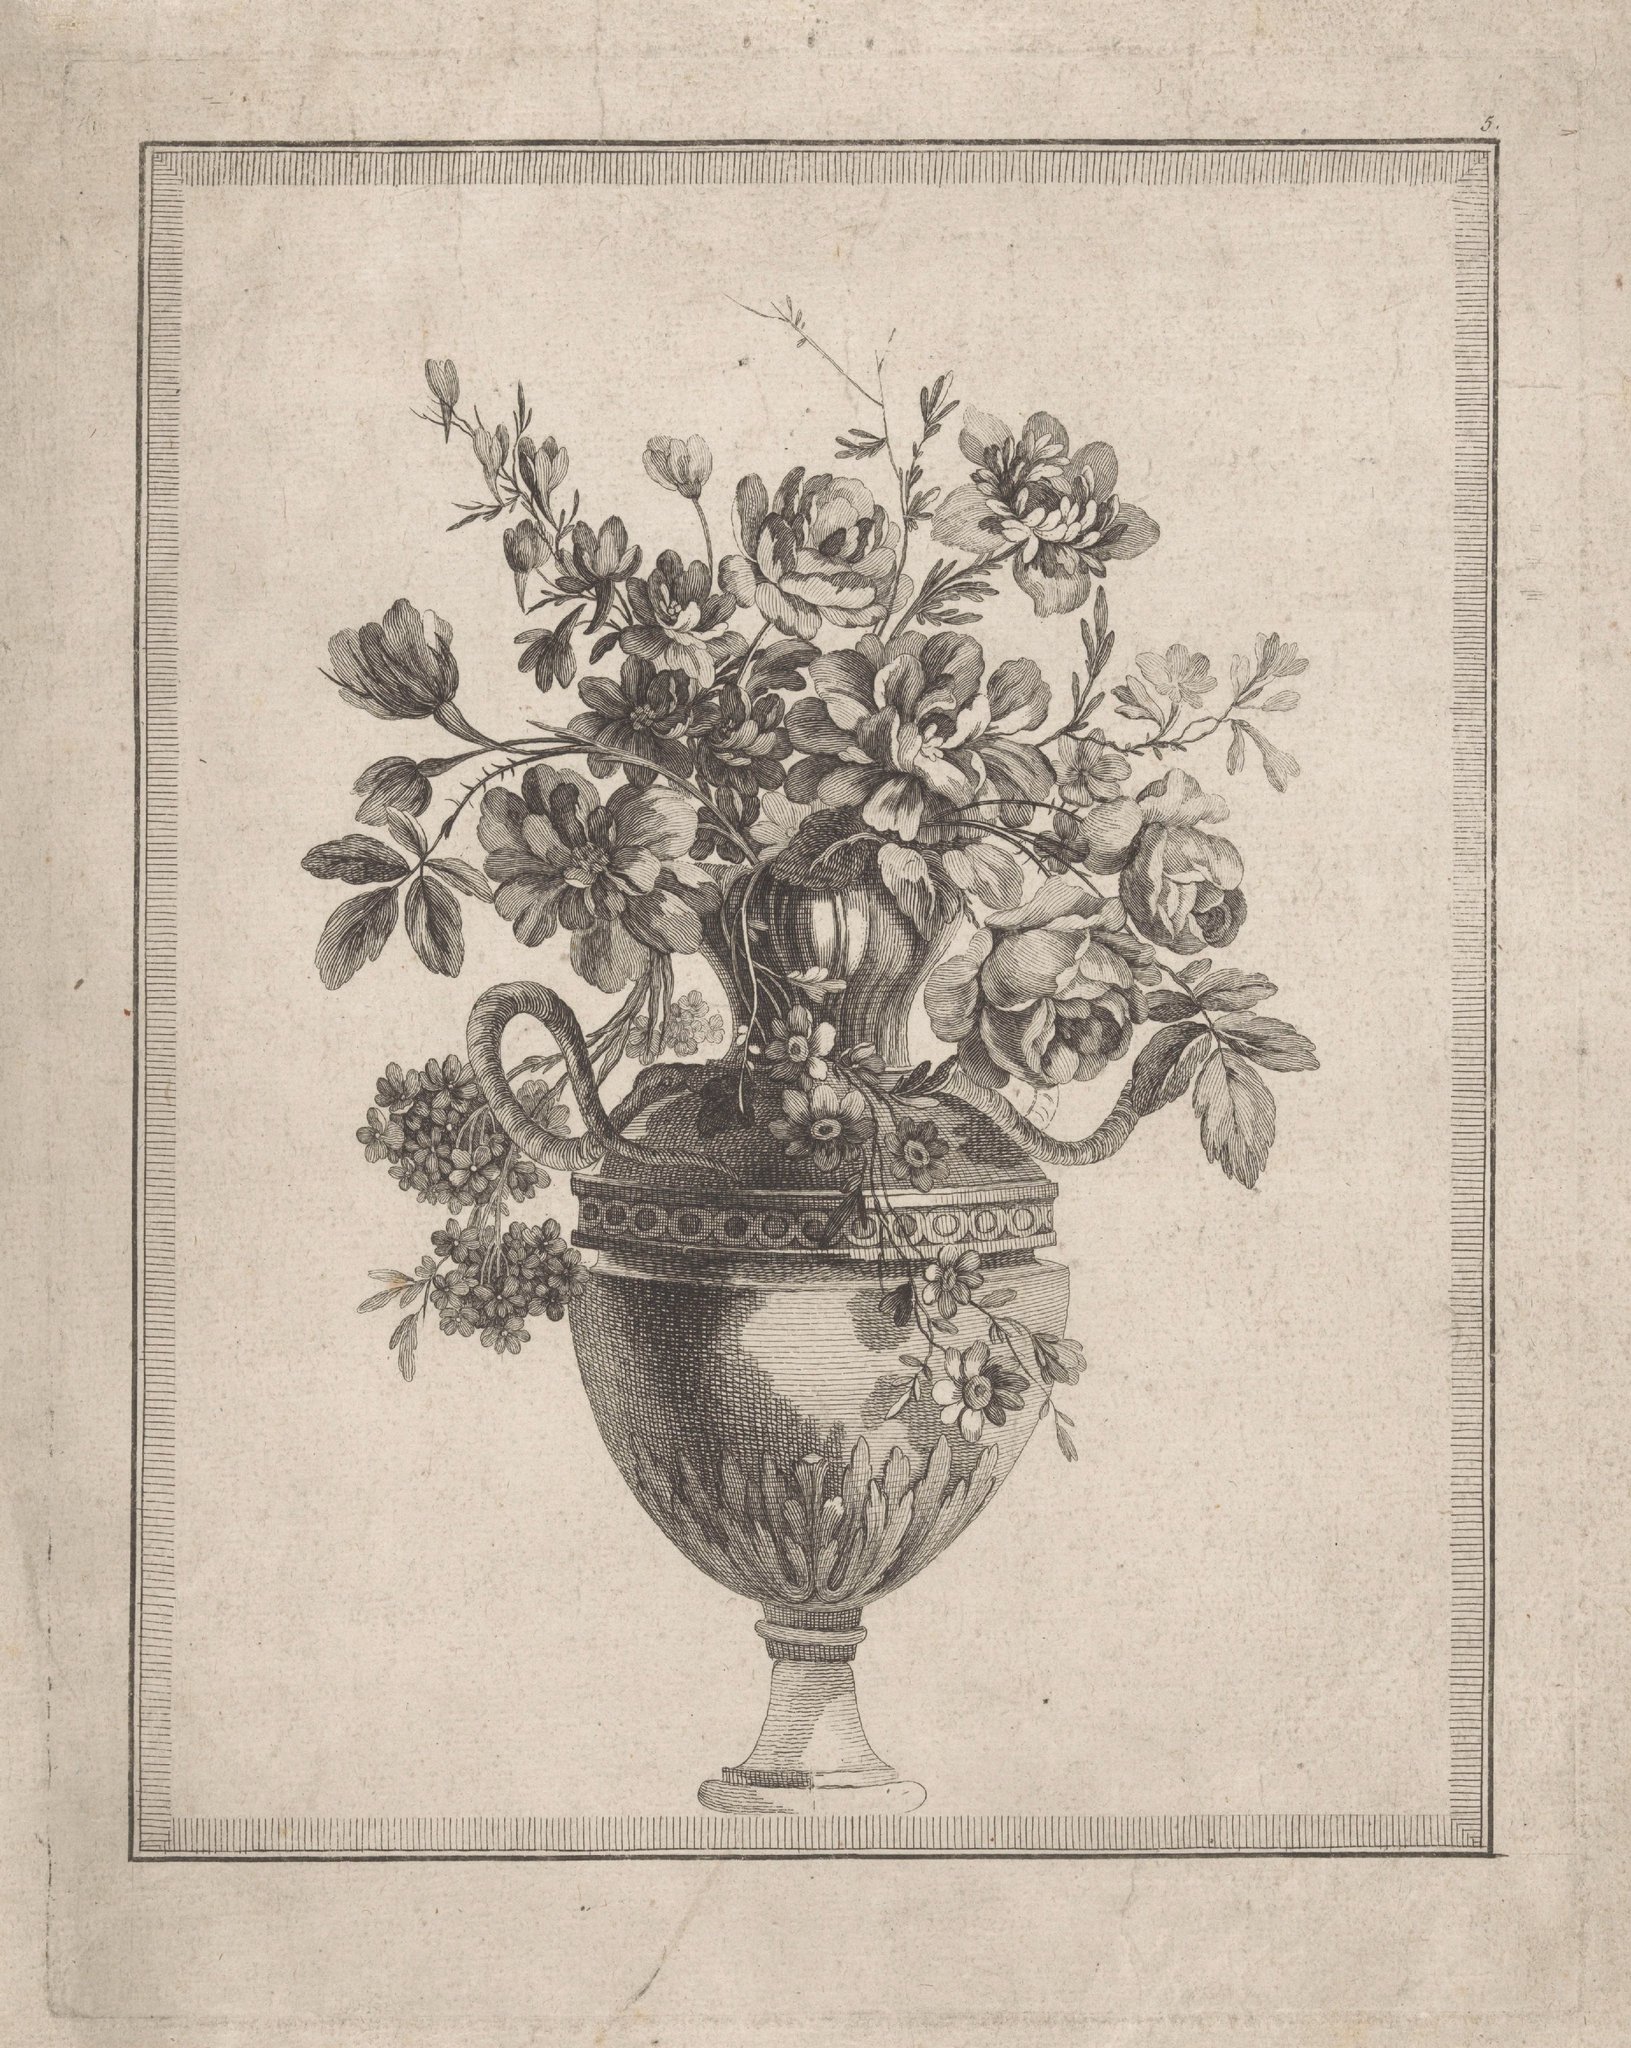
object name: ornament print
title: Bloemen in vaas met slangen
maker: etienne claude voysard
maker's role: print maker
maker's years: 1746-1812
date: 1778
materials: paper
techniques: etching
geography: paris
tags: snakes, flowers in a vase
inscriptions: collector's mark: Lugt 2228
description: Bloemen in een geornamenteerde vaas met slangen.